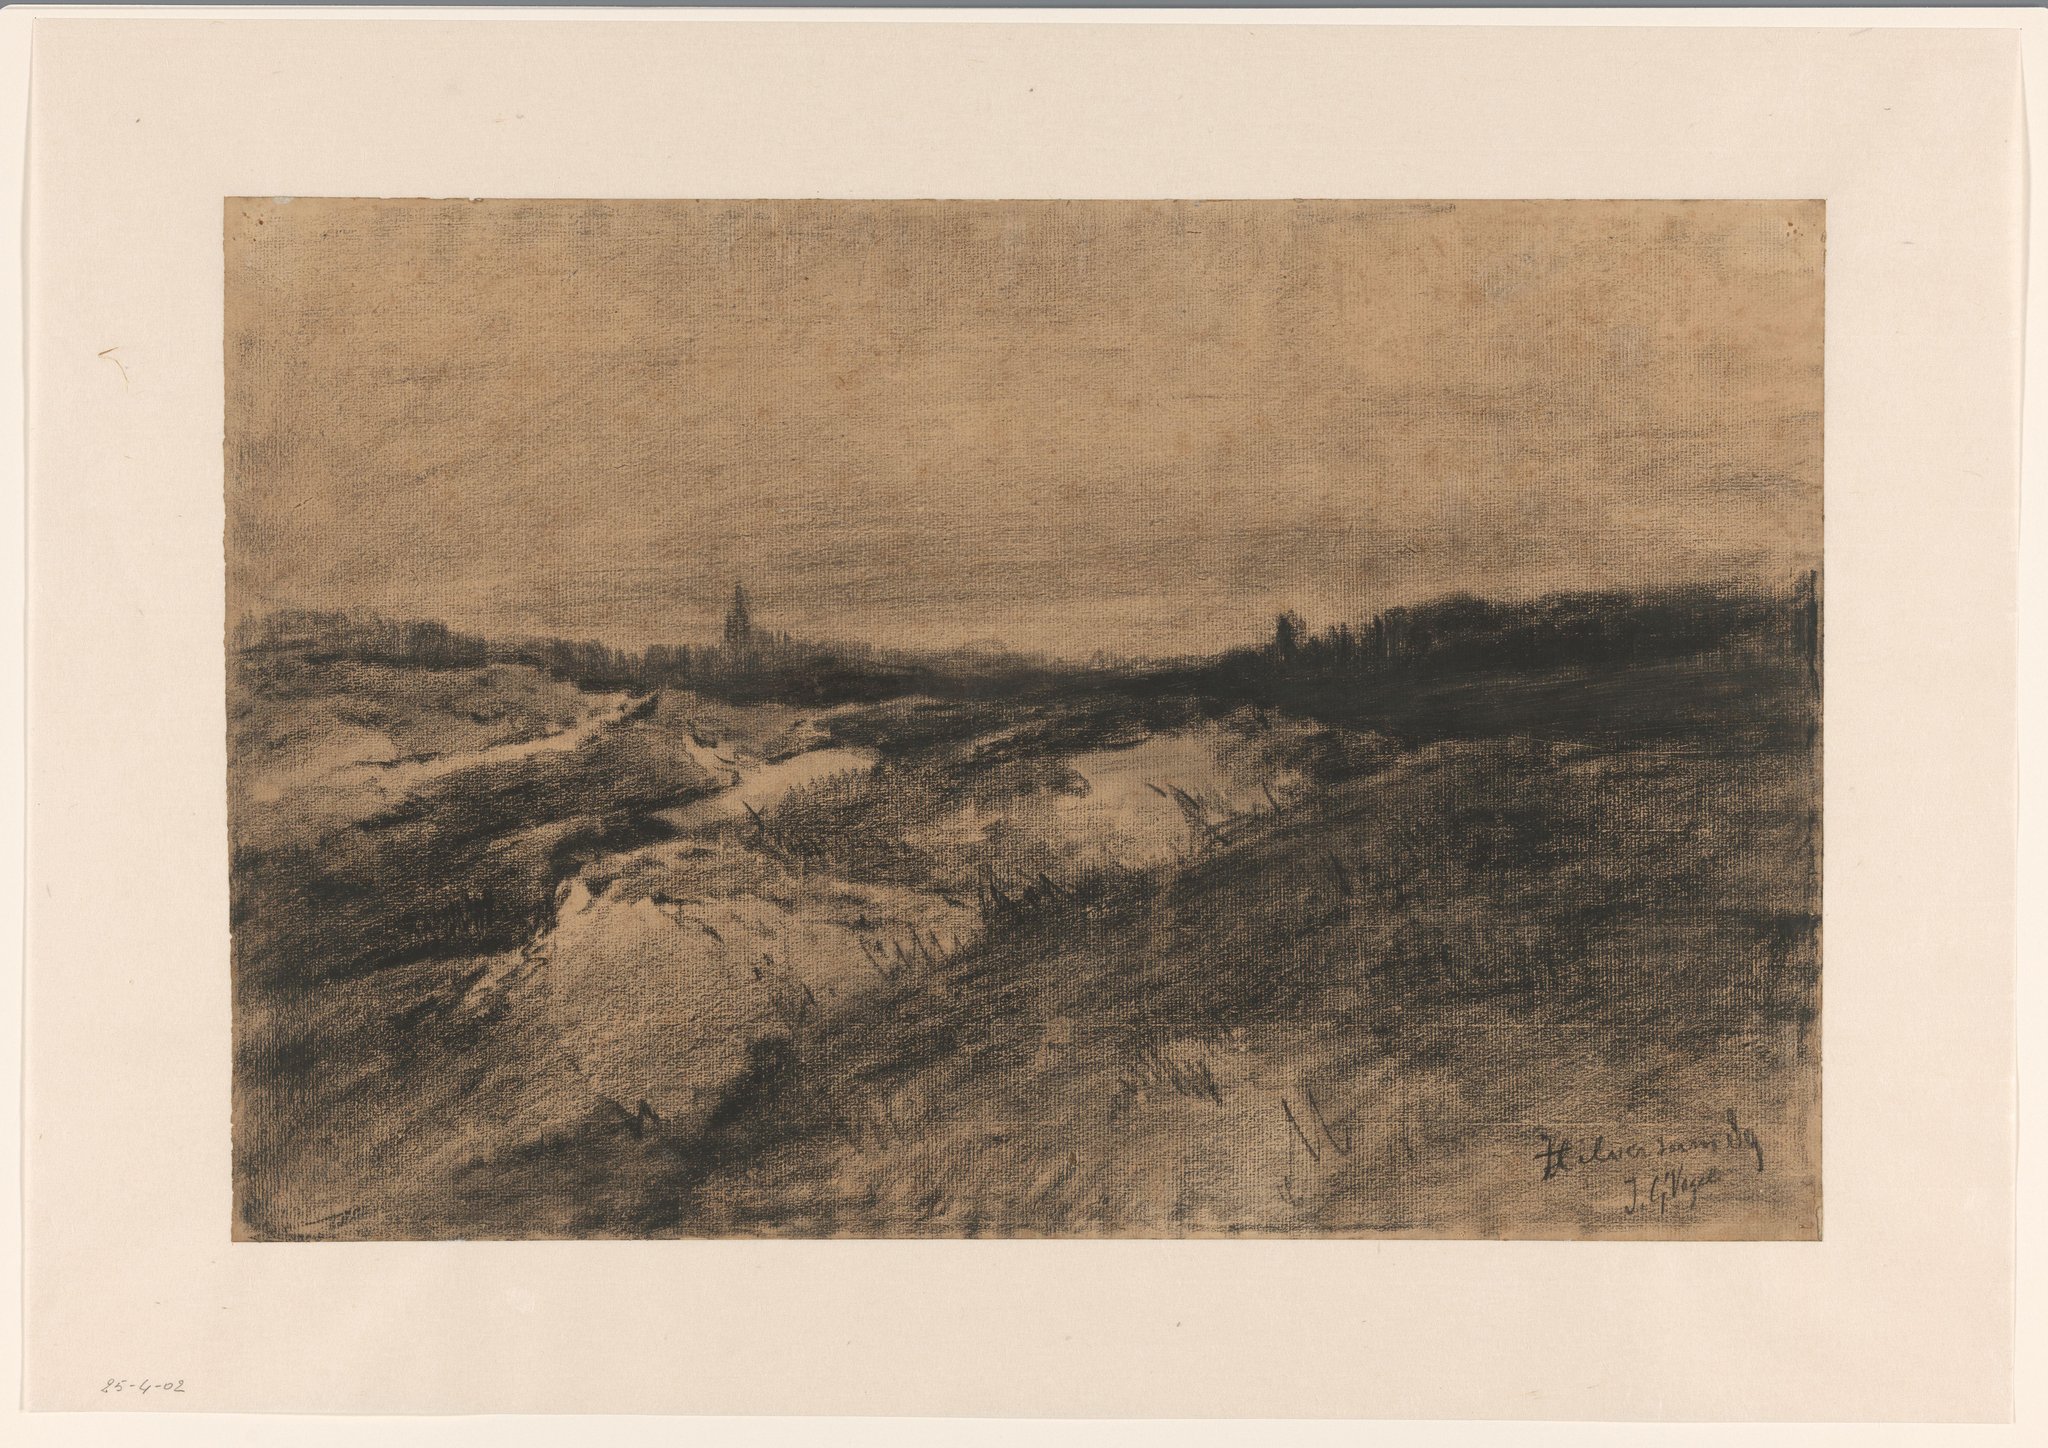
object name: drawing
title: Landschap in de omgeving van Hilversum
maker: johannes gijsbert vogel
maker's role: draughtsman, painter, print maker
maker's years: 1828-1915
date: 1889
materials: chalk, paper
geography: hilversum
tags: public convenience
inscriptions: date